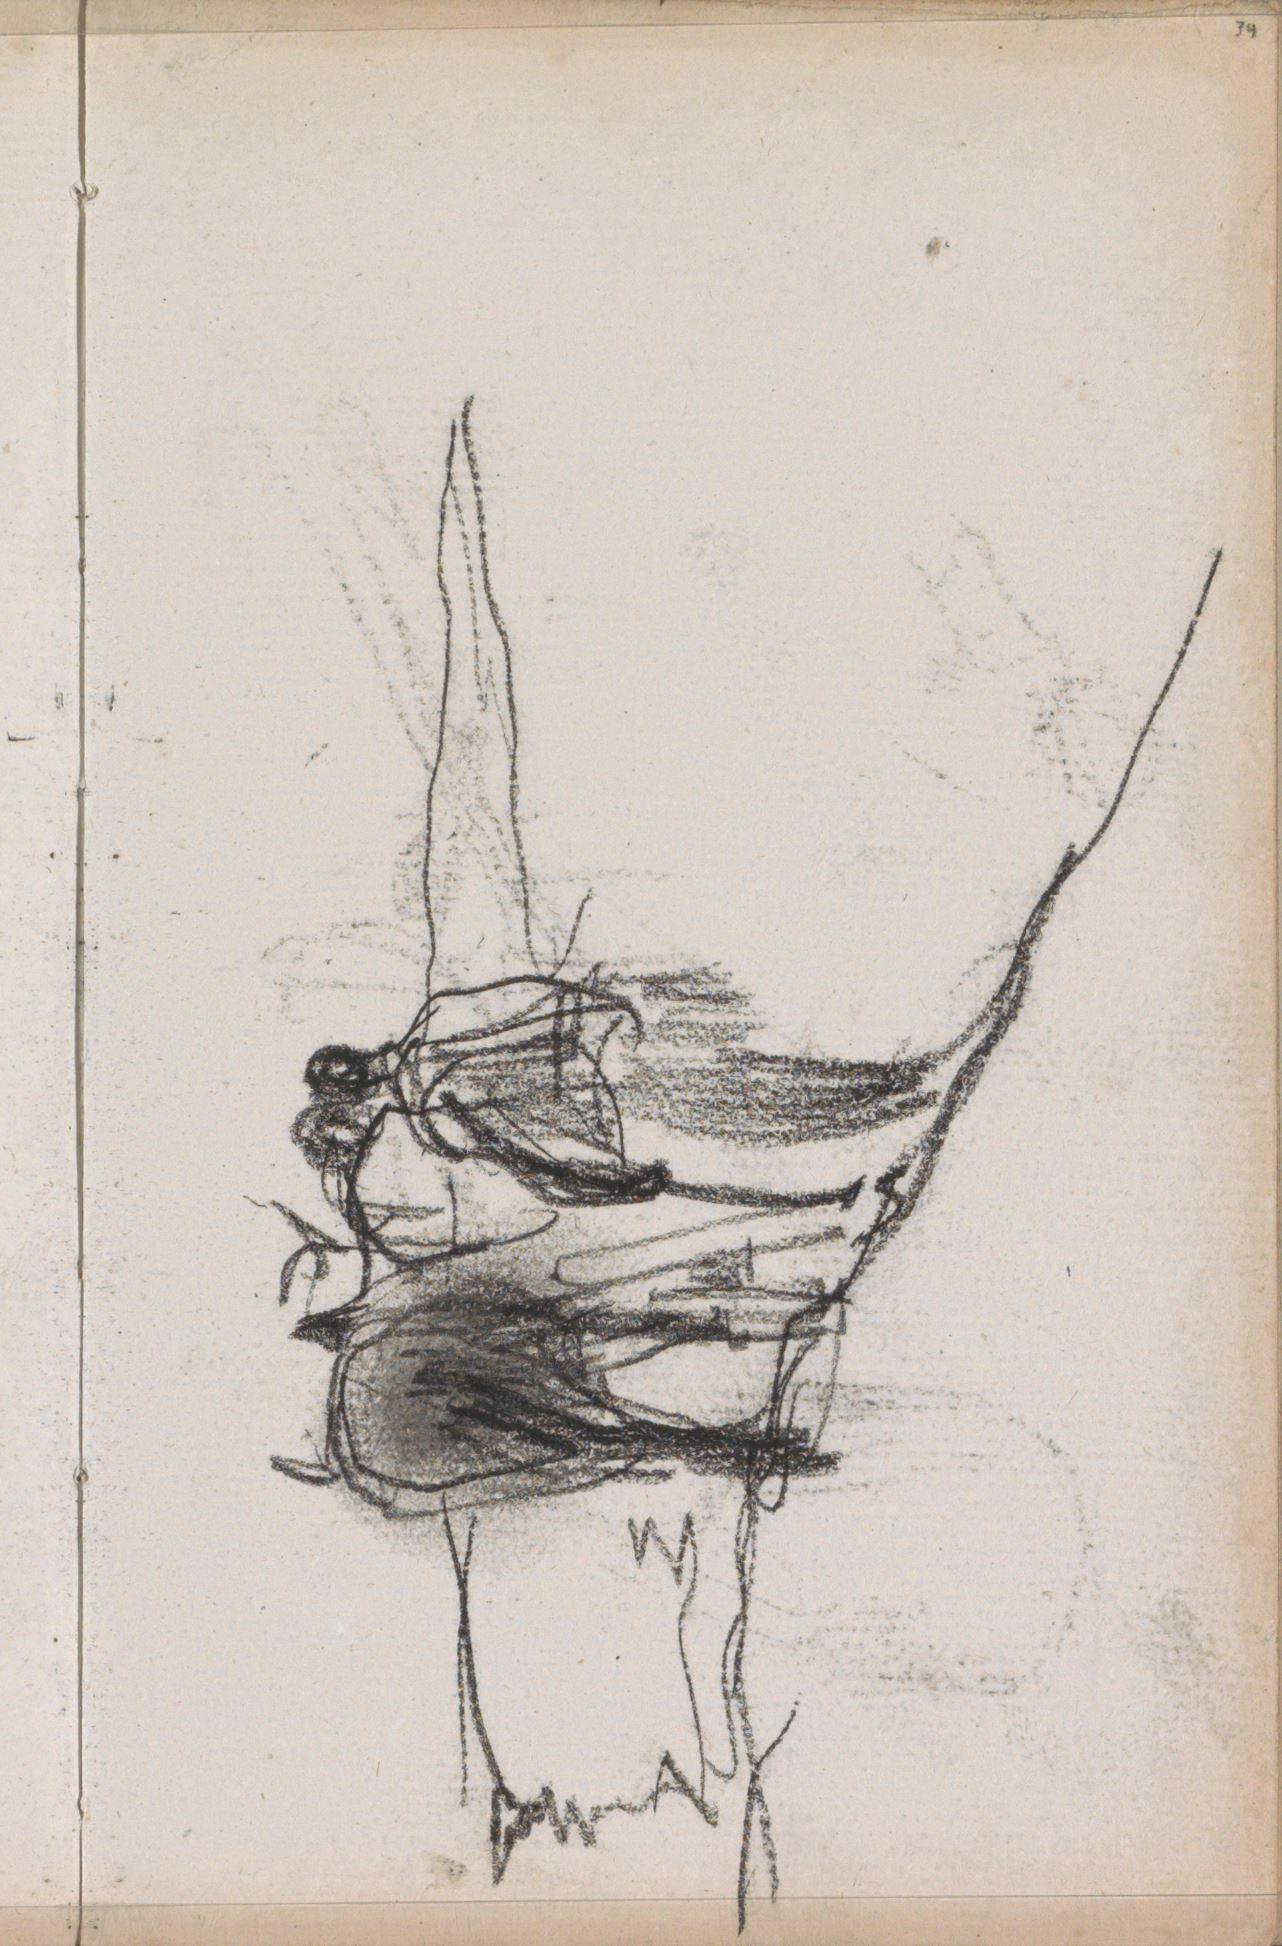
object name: sketchbook leaf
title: Boer achter een ploeg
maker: george hendrik breitner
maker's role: draughtsman, painter, print maker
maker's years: 1857-1923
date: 1884-1886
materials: chalk, paper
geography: drenthe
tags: farmers, horse, agricultural implements: plough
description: De ploeg wordt mogelijk door twee paarden getrokken. Pagina 34 uit een schetsboek met 67 bladen vervaardigd in Drenthe.